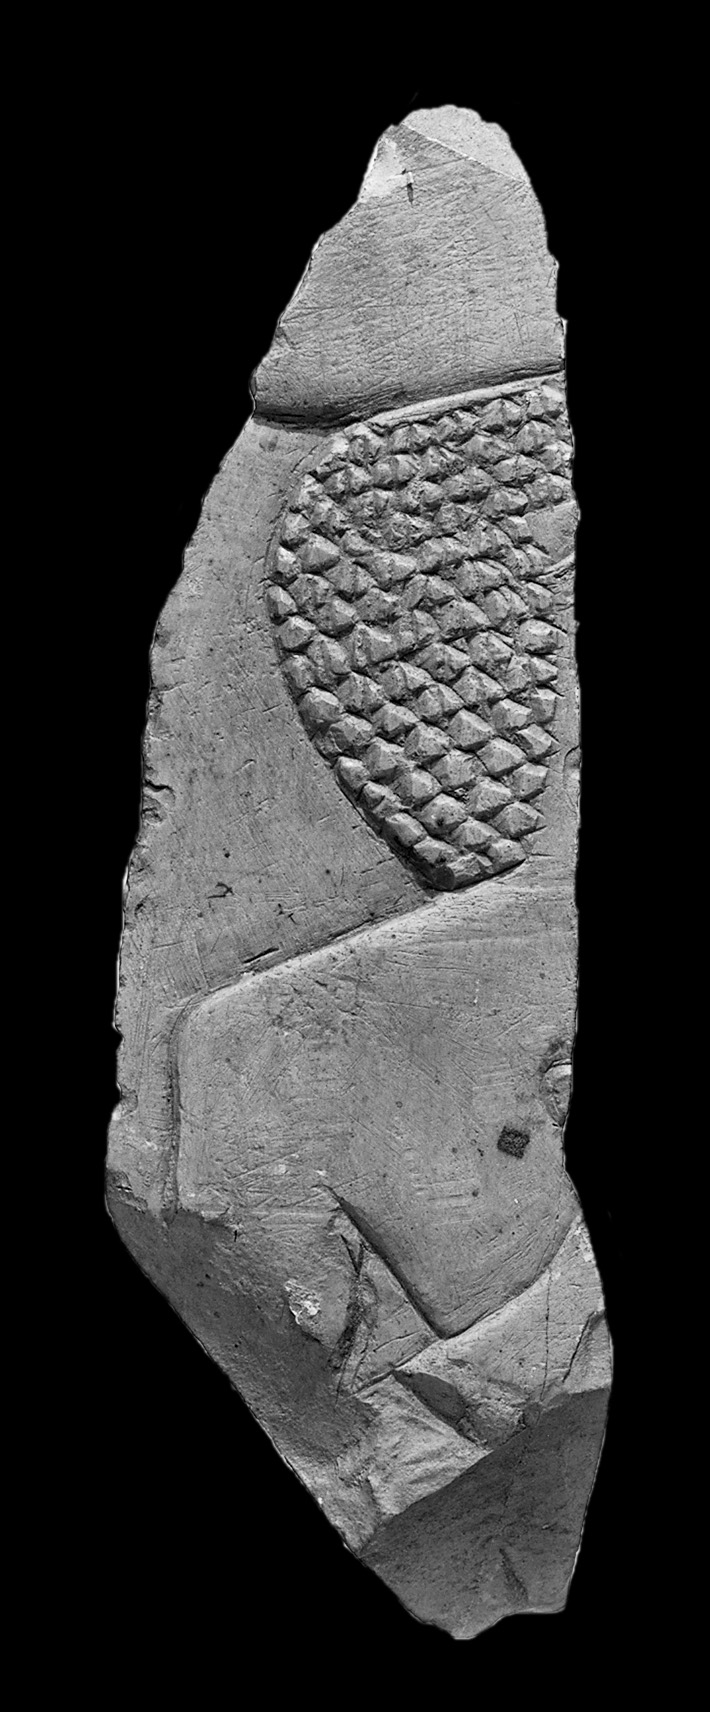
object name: relief, tomb of nespekashuty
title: Raised relief fragment with a male offering bearer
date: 664-610 BCE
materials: limestone, varnish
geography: egypt